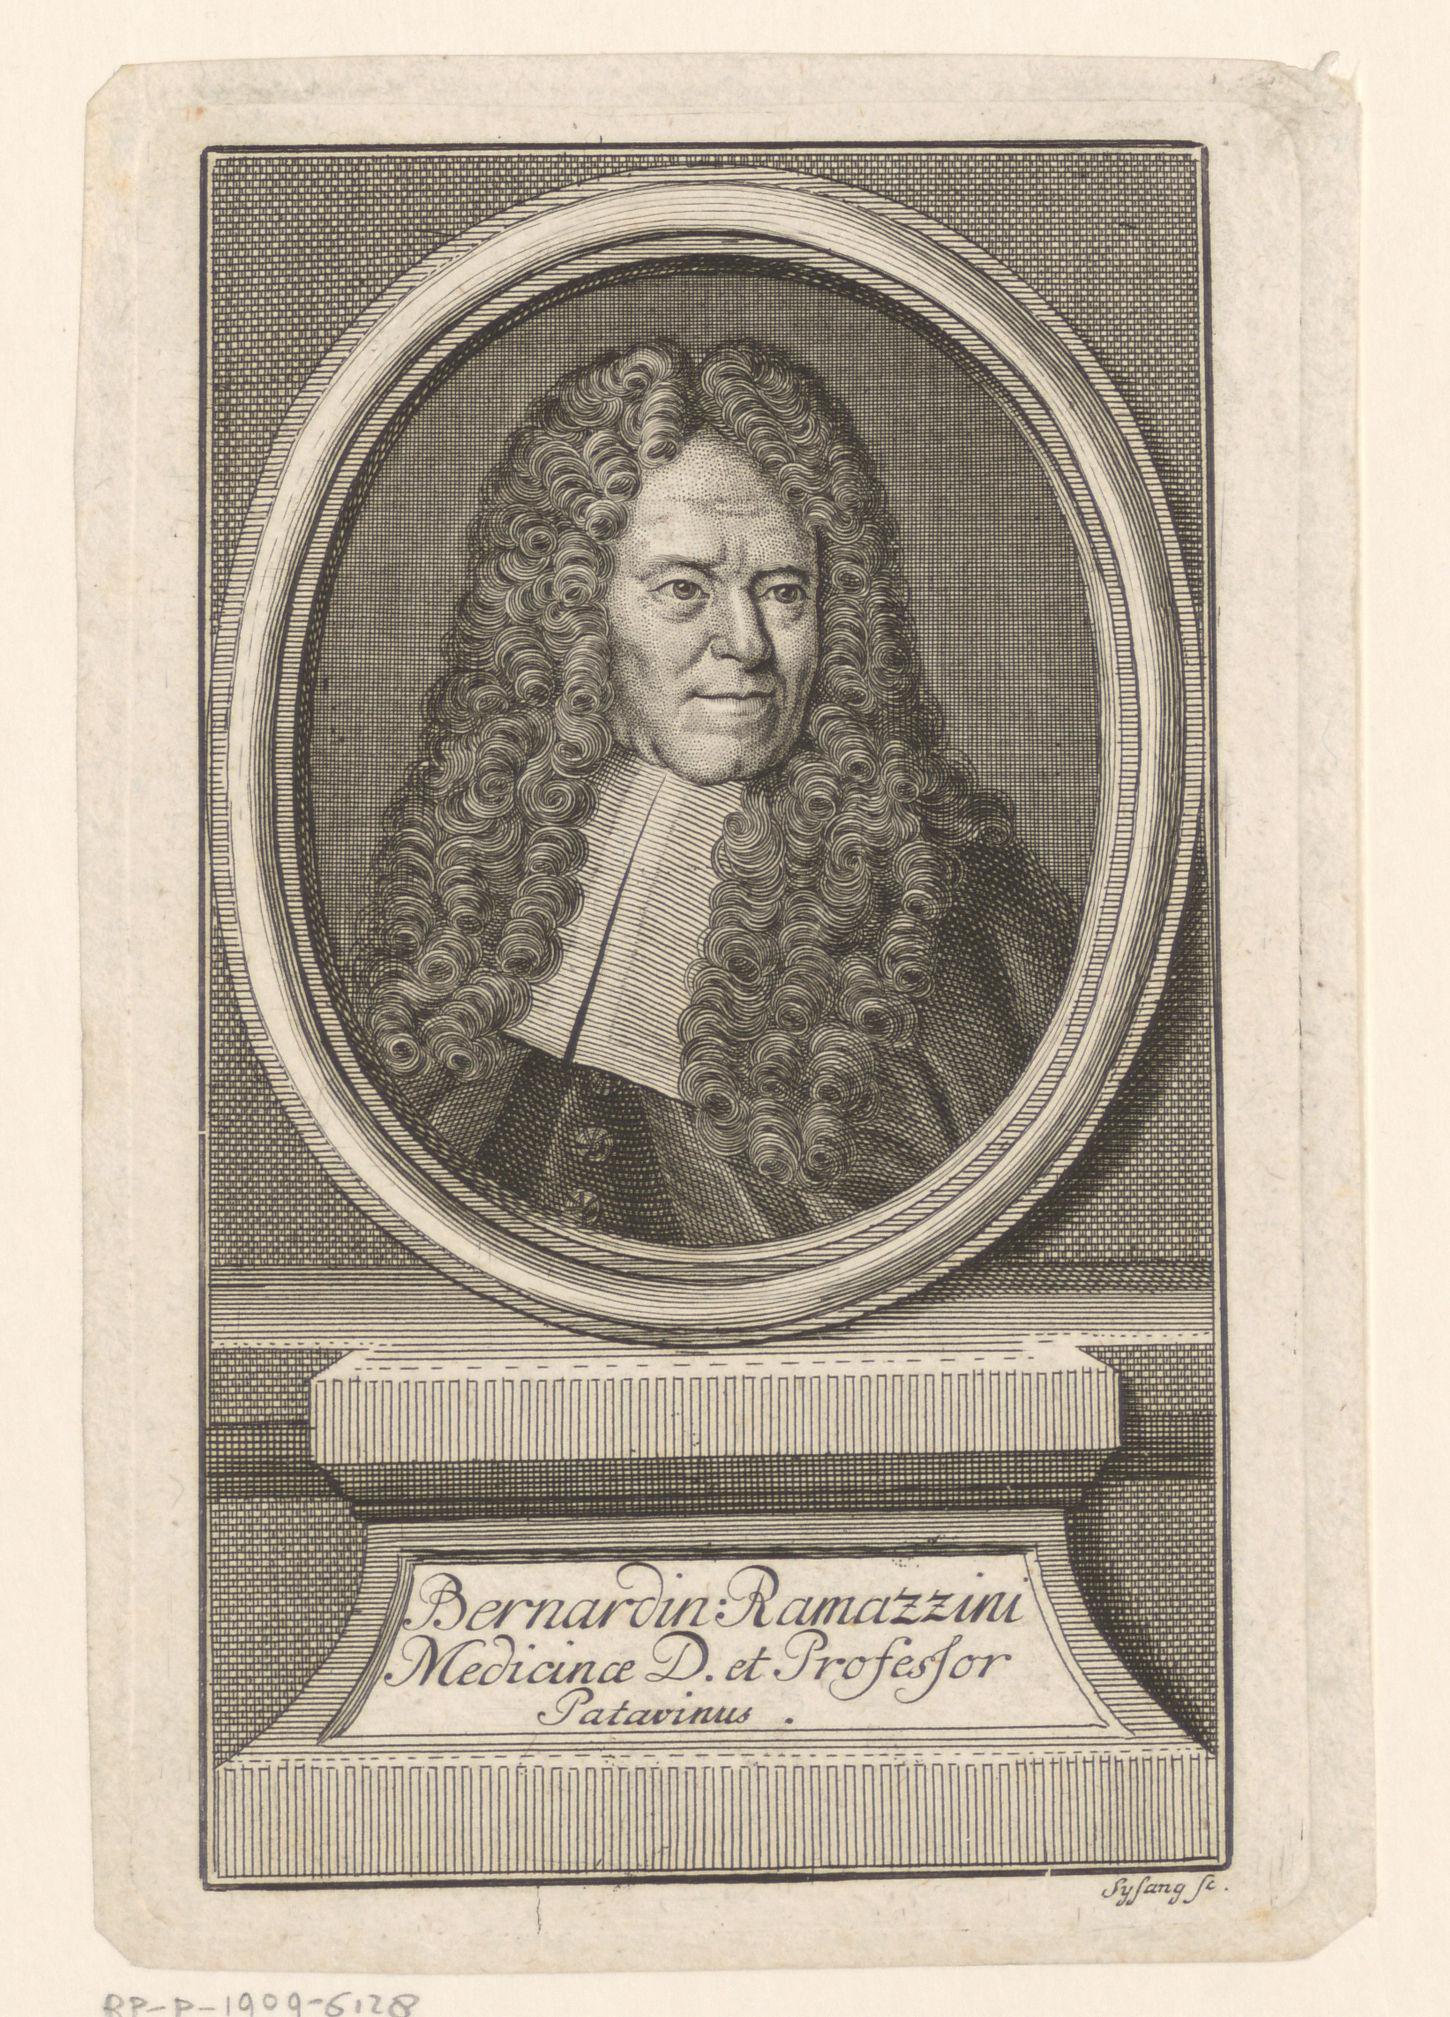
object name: print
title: Portret van Bernardino Ramazzini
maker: johann christoph sysang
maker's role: print maker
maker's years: 1703-1757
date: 1748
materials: paper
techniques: engraving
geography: leipzig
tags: historical persons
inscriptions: collector's mark: Lugt 2228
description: Prent gebruikt voor de publicatie: Zuverlässige Nachrichten von dem gegenwärtigen Zustande, Veränderung und Wachsthum der Wissenschaften. Leipzig: Johann Friedrich Gleditsch, 1748, dl. 108.